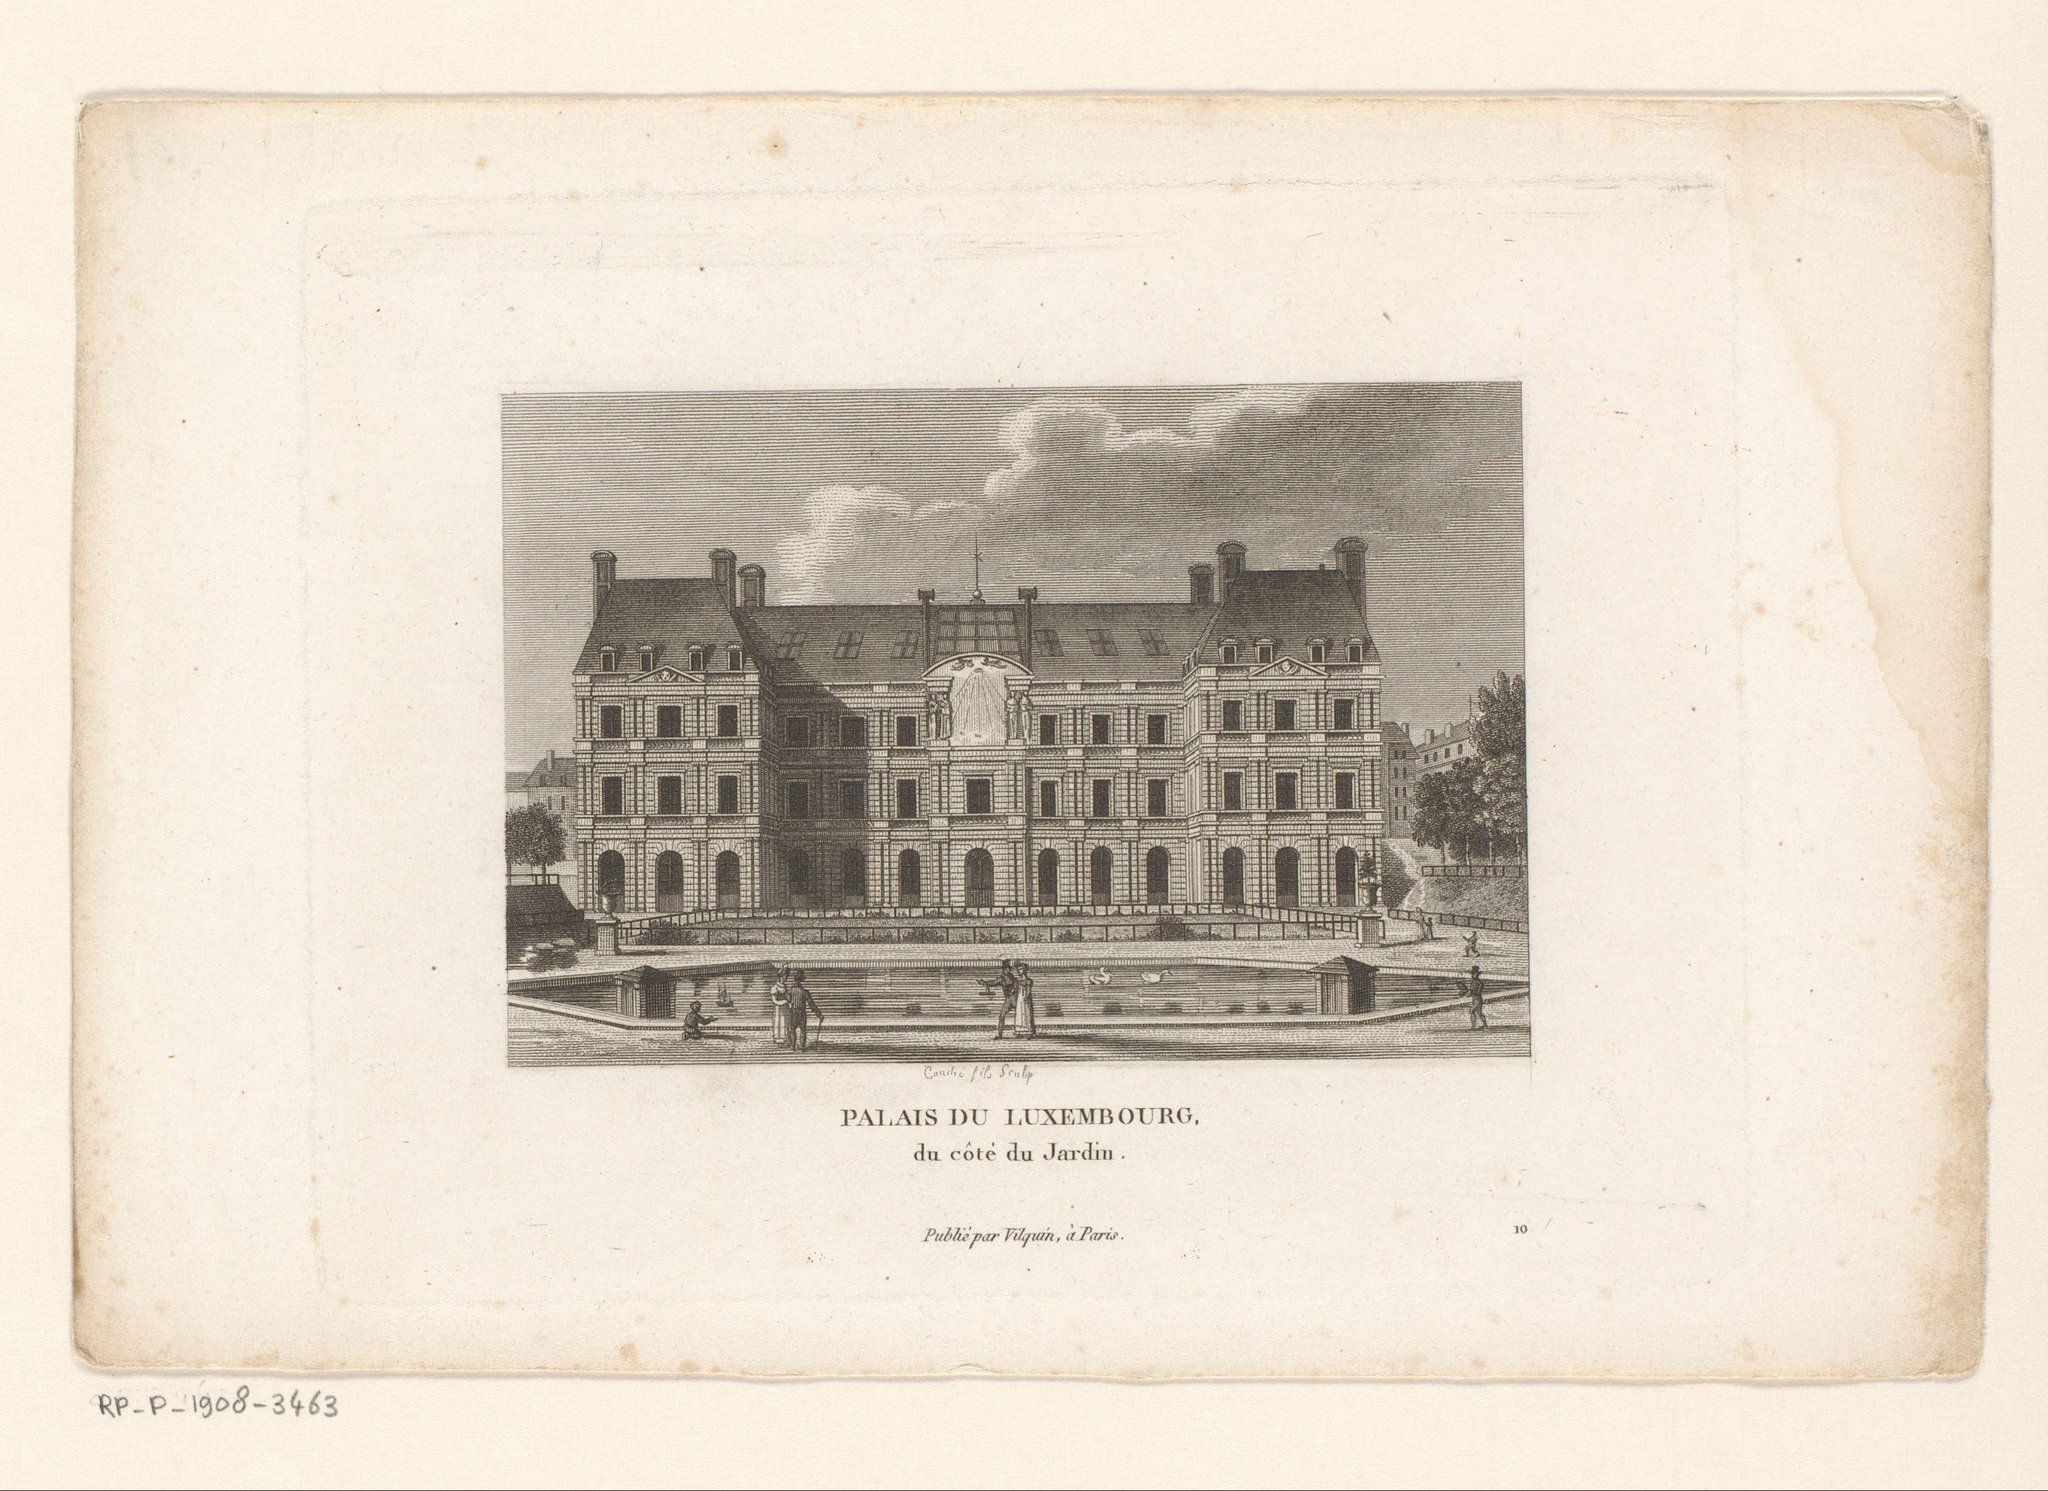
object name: print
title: Palais du Luxembourg.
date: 1818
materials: paper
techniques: etching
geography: paris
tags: city-view in general; 'veduta', palace, paris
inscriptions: collector's mark: Lugt 2228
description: Maakt deel uit van een serie met 60 platen van monumenten, kathedralen en paleizen in Parijs.